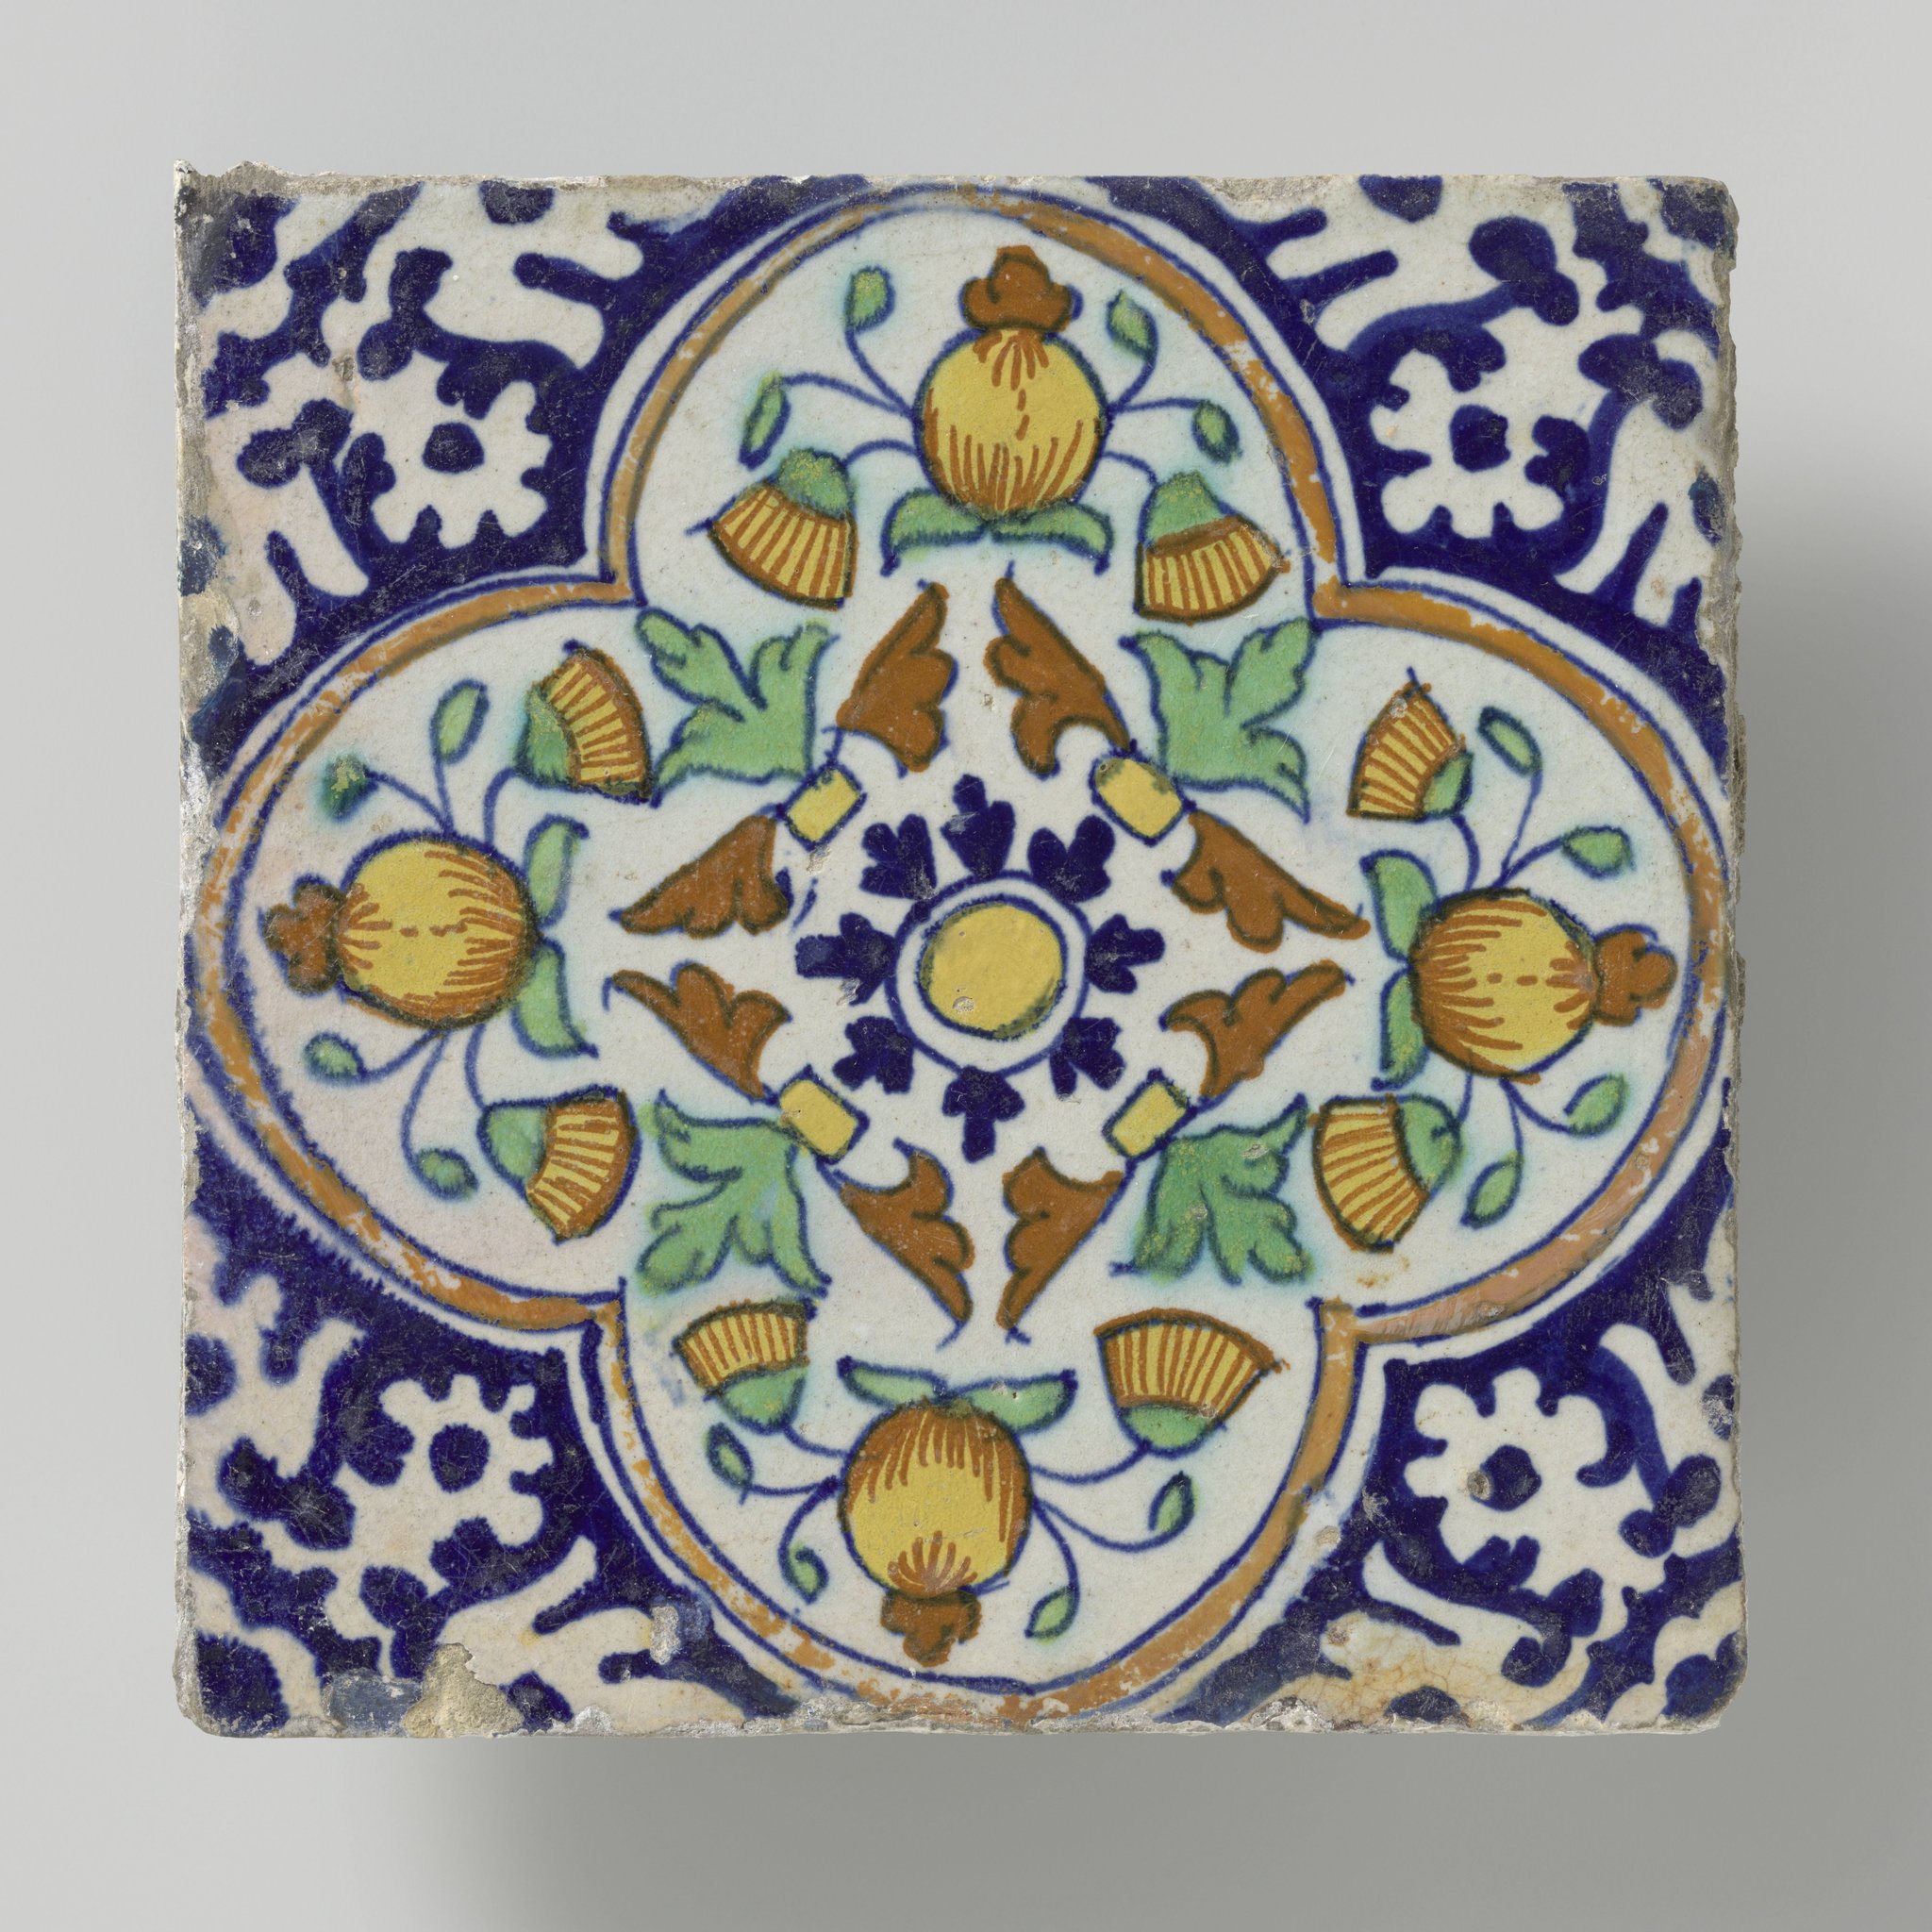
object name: pompadourtegel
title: Pompadourtegel met rozet omgeven door granaatappels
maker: Anonymous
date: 1600-1625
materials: earthenware, glaze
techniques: maiolica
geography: netherlands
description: Pompadourtegel met een veelkleurige (blauw, oranje, groen en geel) geschilderde rozet omgeven door granaatappels en goudsbloemen binnen een vierpas. In de hoeken, vultechniek ornament.